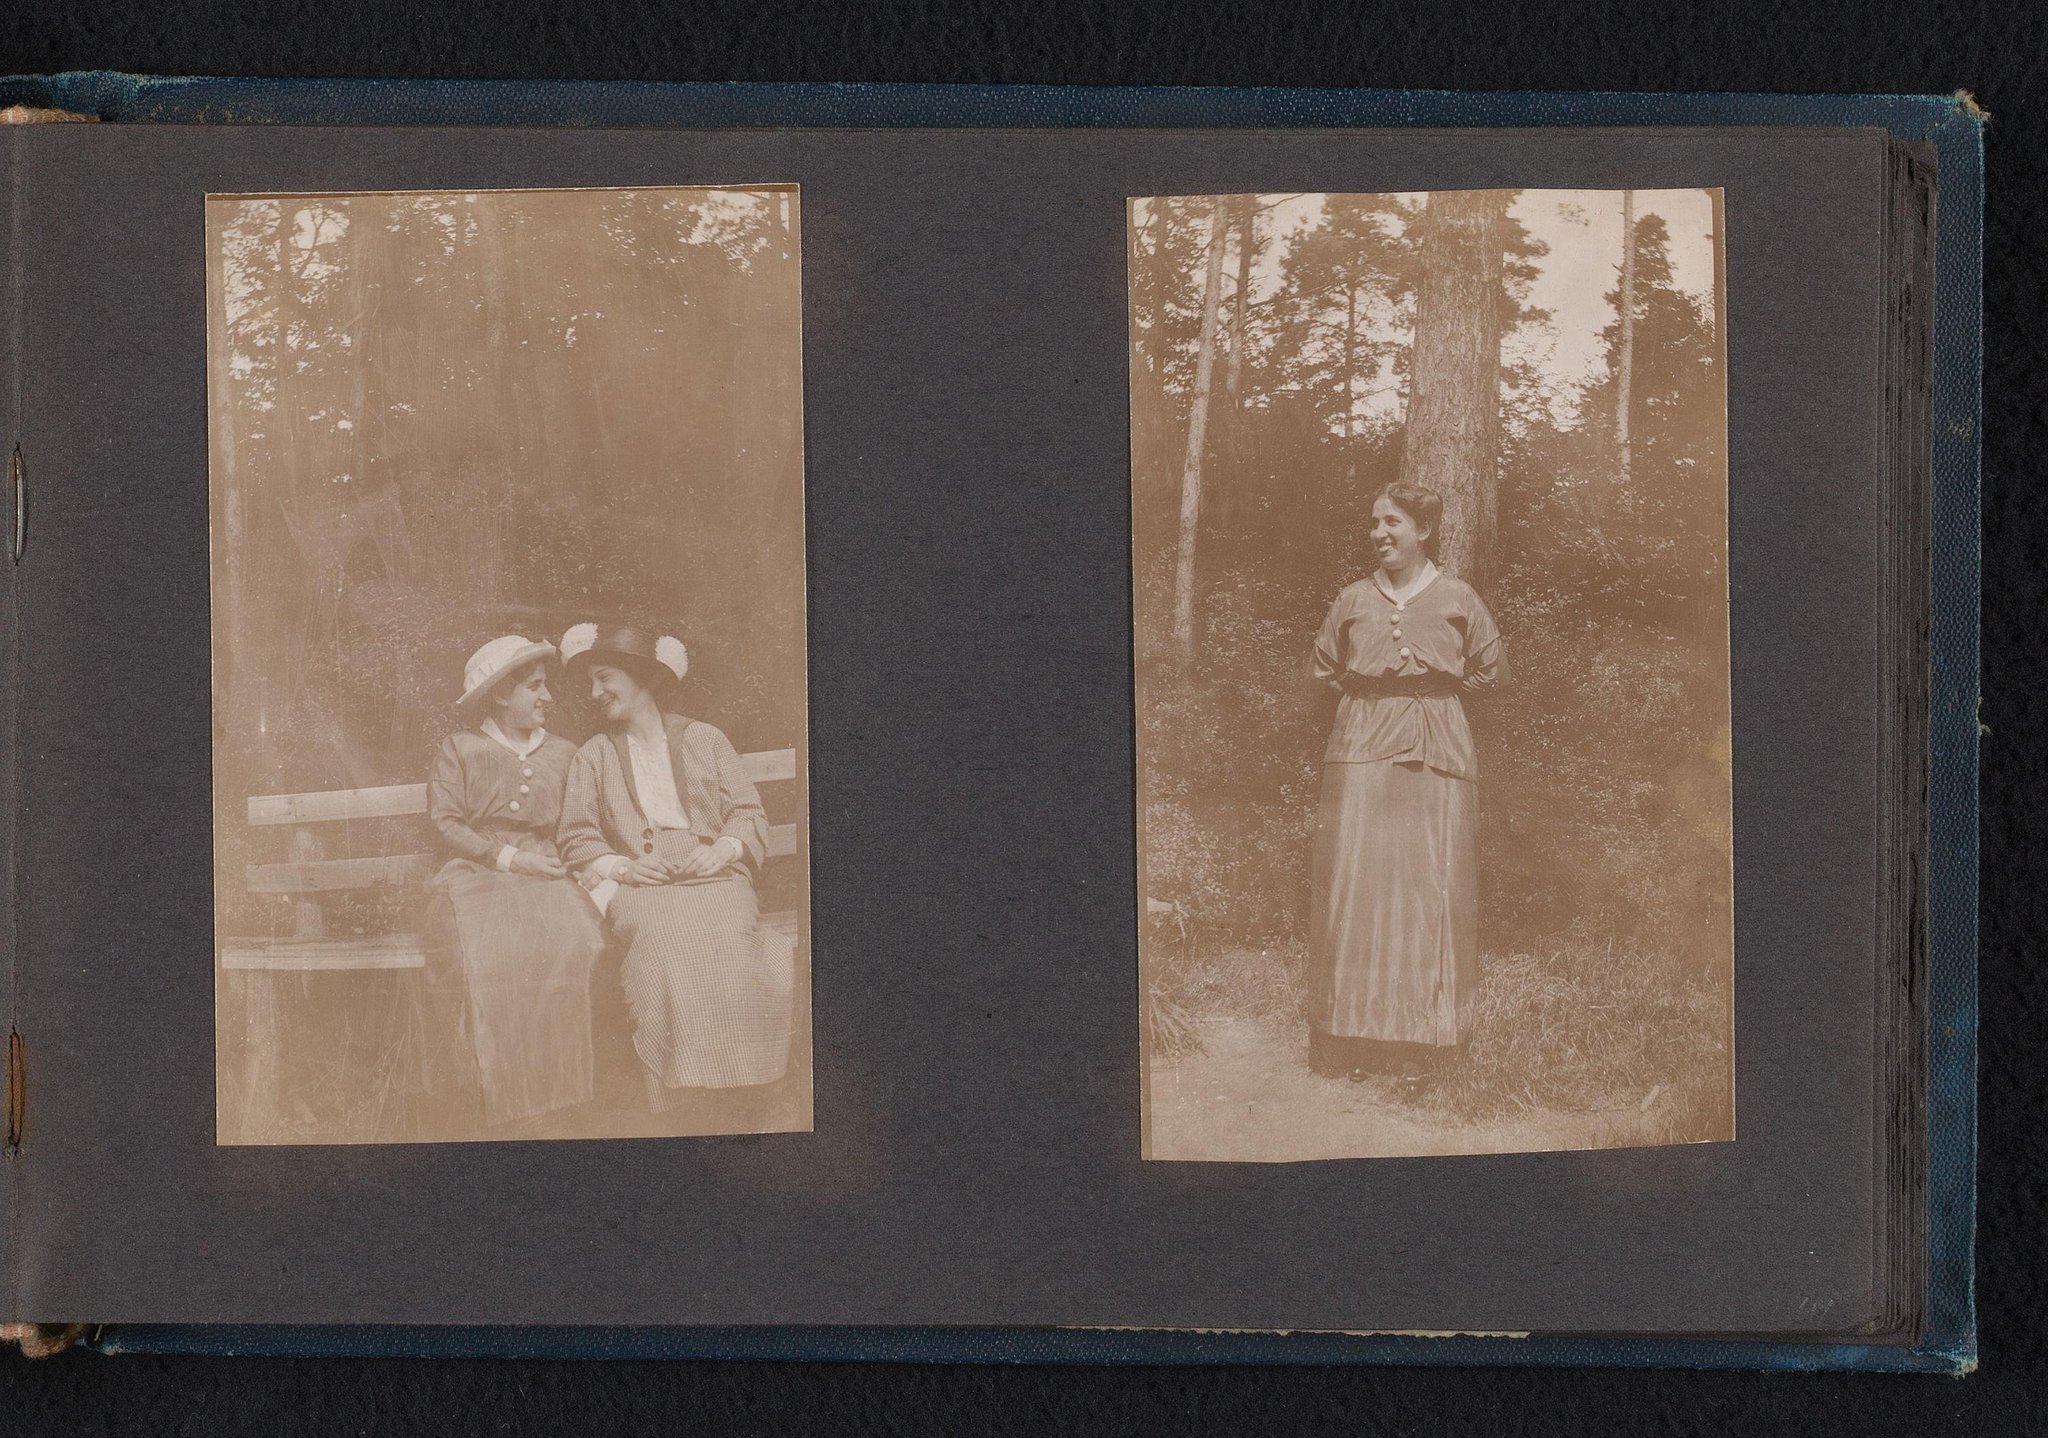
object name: photograph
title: Else en vriendinnen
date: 1914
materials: paper, photographic support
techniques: gelatin silver print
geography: germany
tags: else wachenheimer-moos, outing, pleasure trip, germany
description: Albumblad met twee foto's van Else met vriendinnen. Onderdeel van het fotoalbum van Else Wachenheimer-Moos en haar broers Arthur en Willy Moos en anderen in de periode 1913-1918.